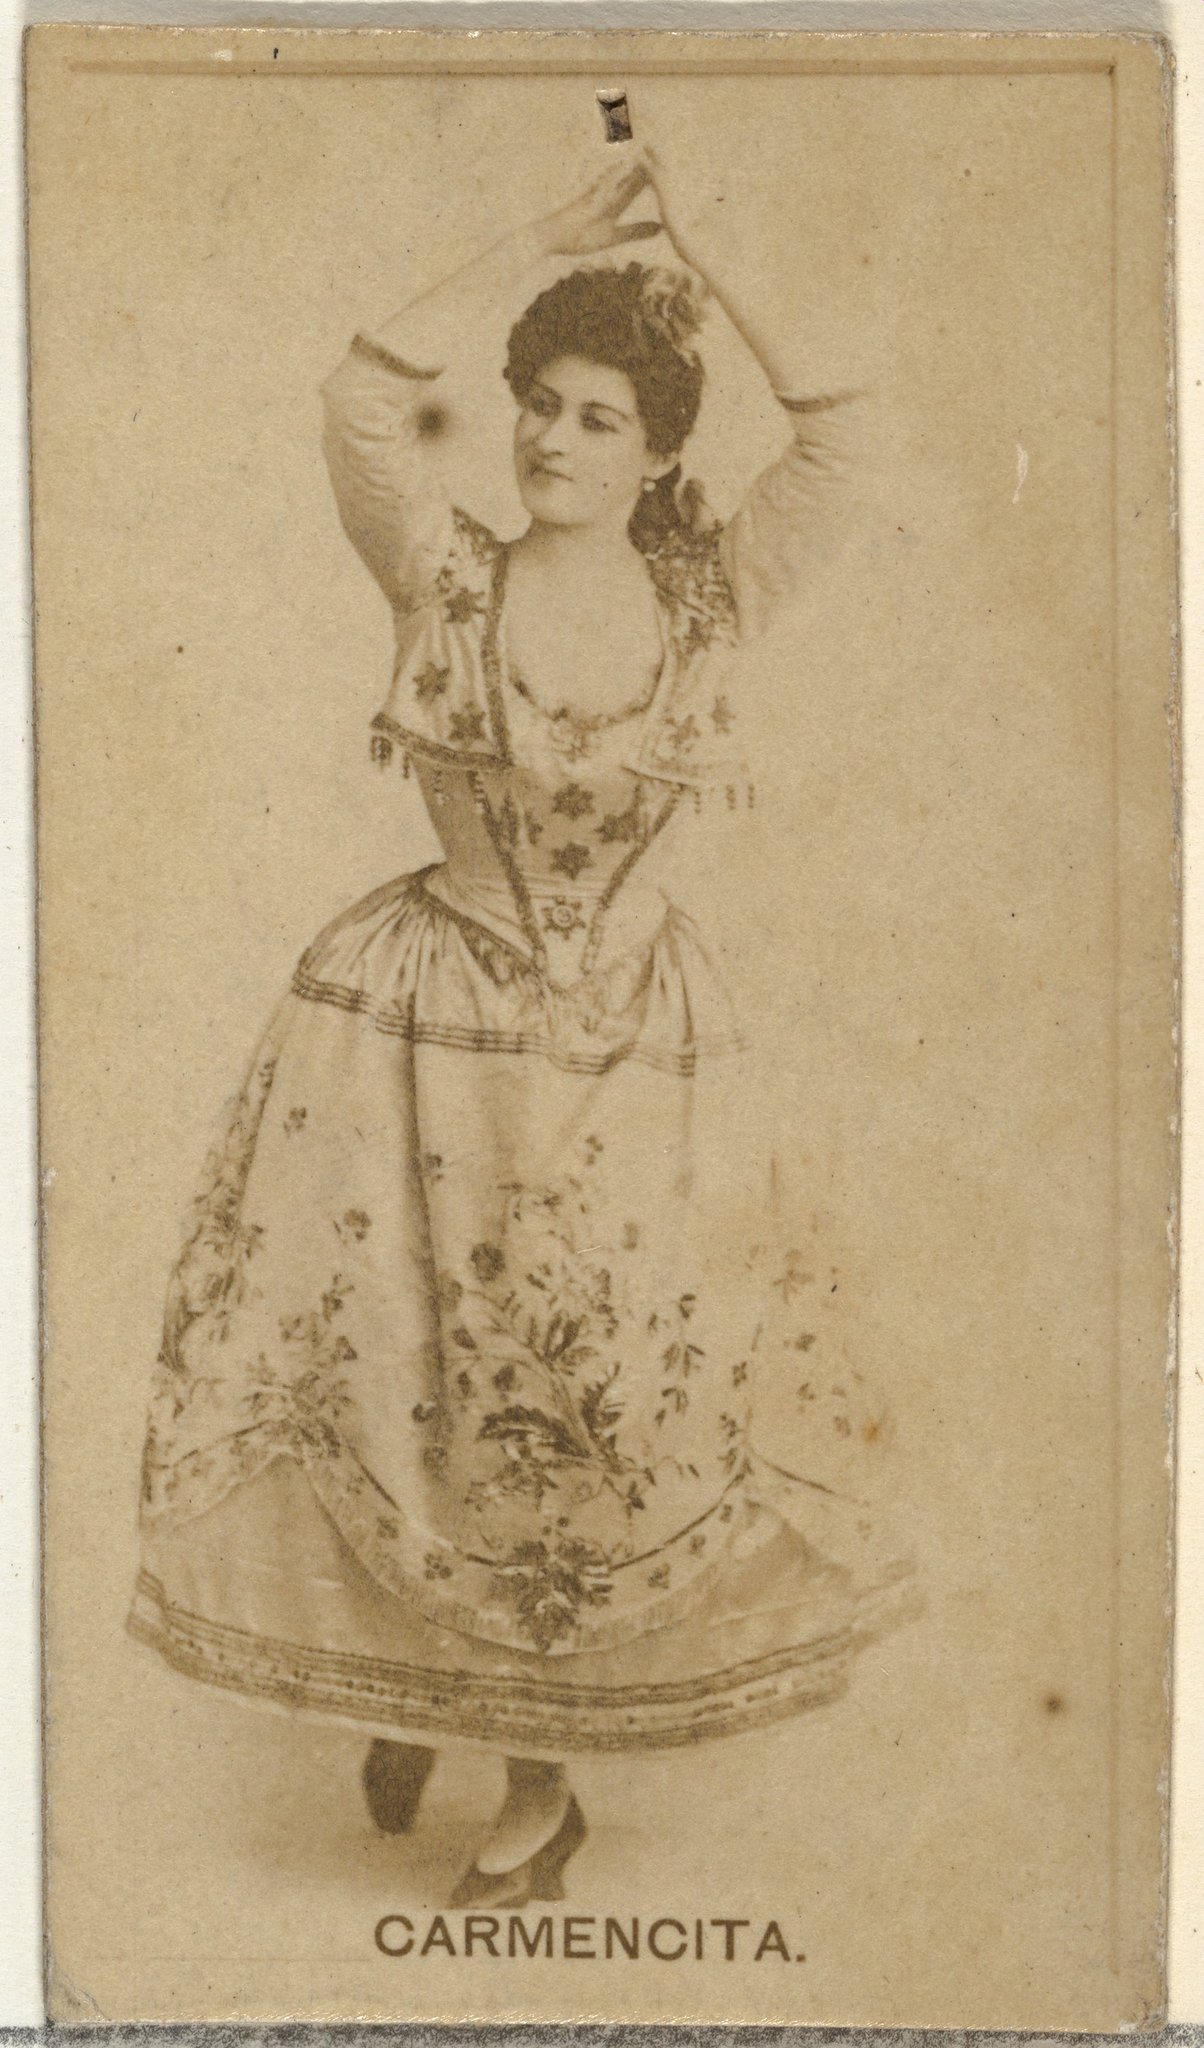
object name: photograph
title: Carmencita, from the Actors and Actresses series (N145-8) issued by Duke Sons & Co. to promote Duke Cigarettes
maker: w. duke, sons & co.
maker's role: publisher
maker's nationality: american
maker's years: 1870-1920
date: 1891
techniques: albumen silver print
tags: portraits,women,actresses